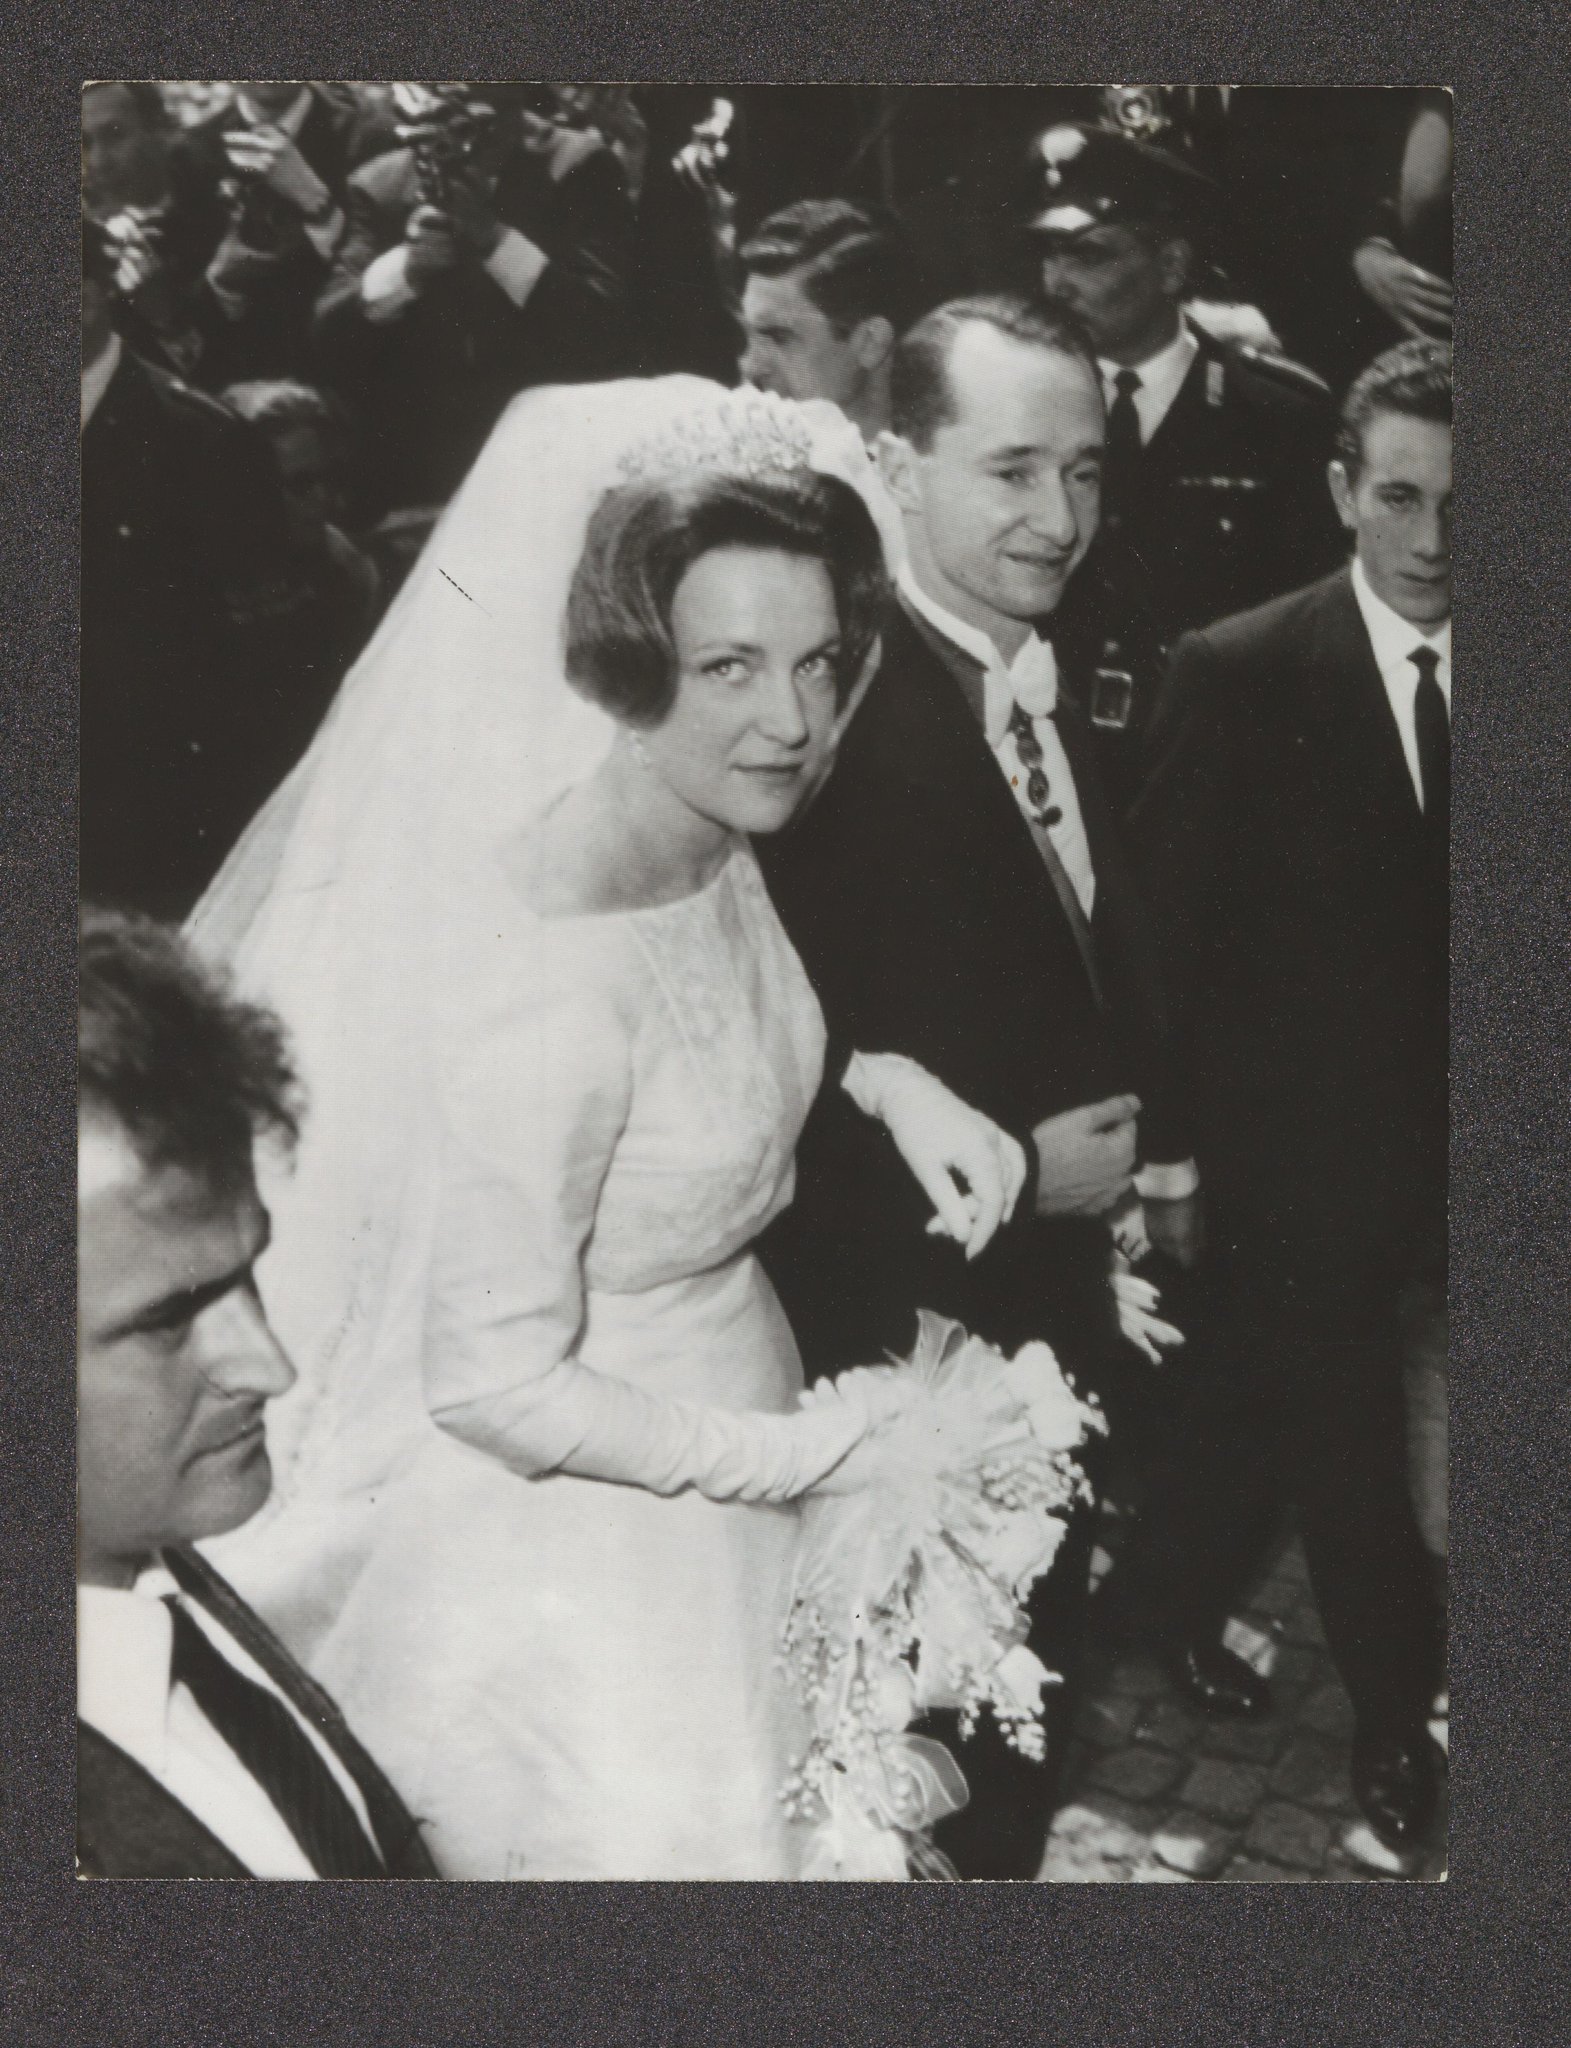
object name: photograph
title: Huwelijksportret van Prinses Irene en en prins Carlos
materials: photographic support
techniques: autotype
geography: netherlands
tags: paris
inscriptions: annotation: ‘La princesse Irene ... qui groupait cinq cent invites’